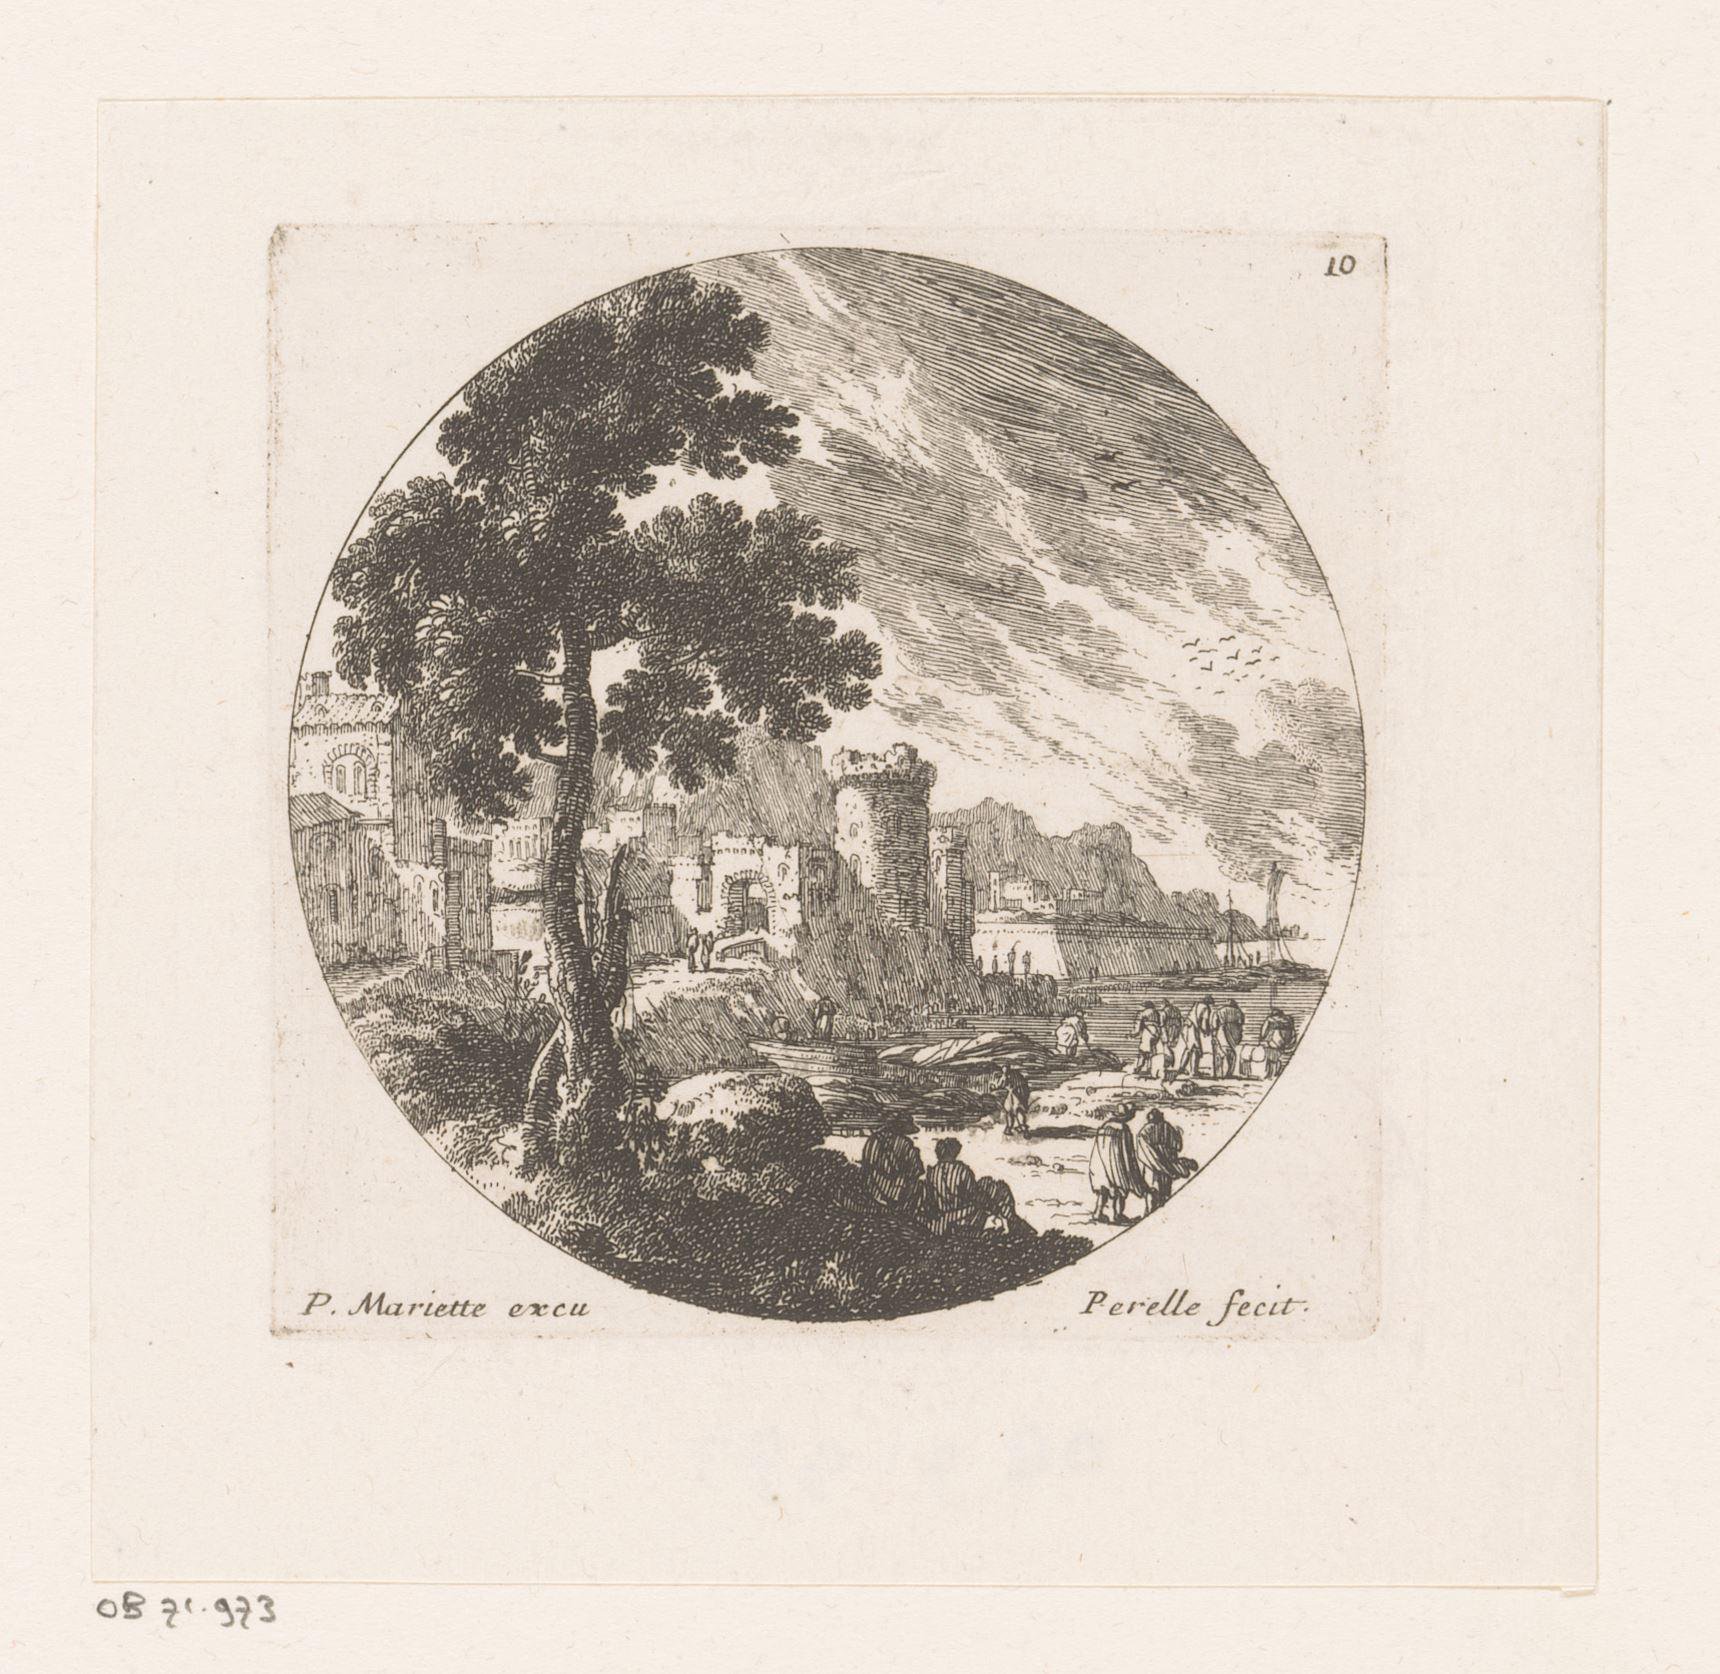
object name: print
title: Figuren buiten een vestingstad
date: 1613-1695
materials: paper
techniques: etching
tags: fortified city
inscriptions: collector's mark: Lugt 240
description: Prenten met het signatuur 'Perelle' kunnen zowel door vader Gabriel als door zonen Nicolas en Adam gemaakt zijn.